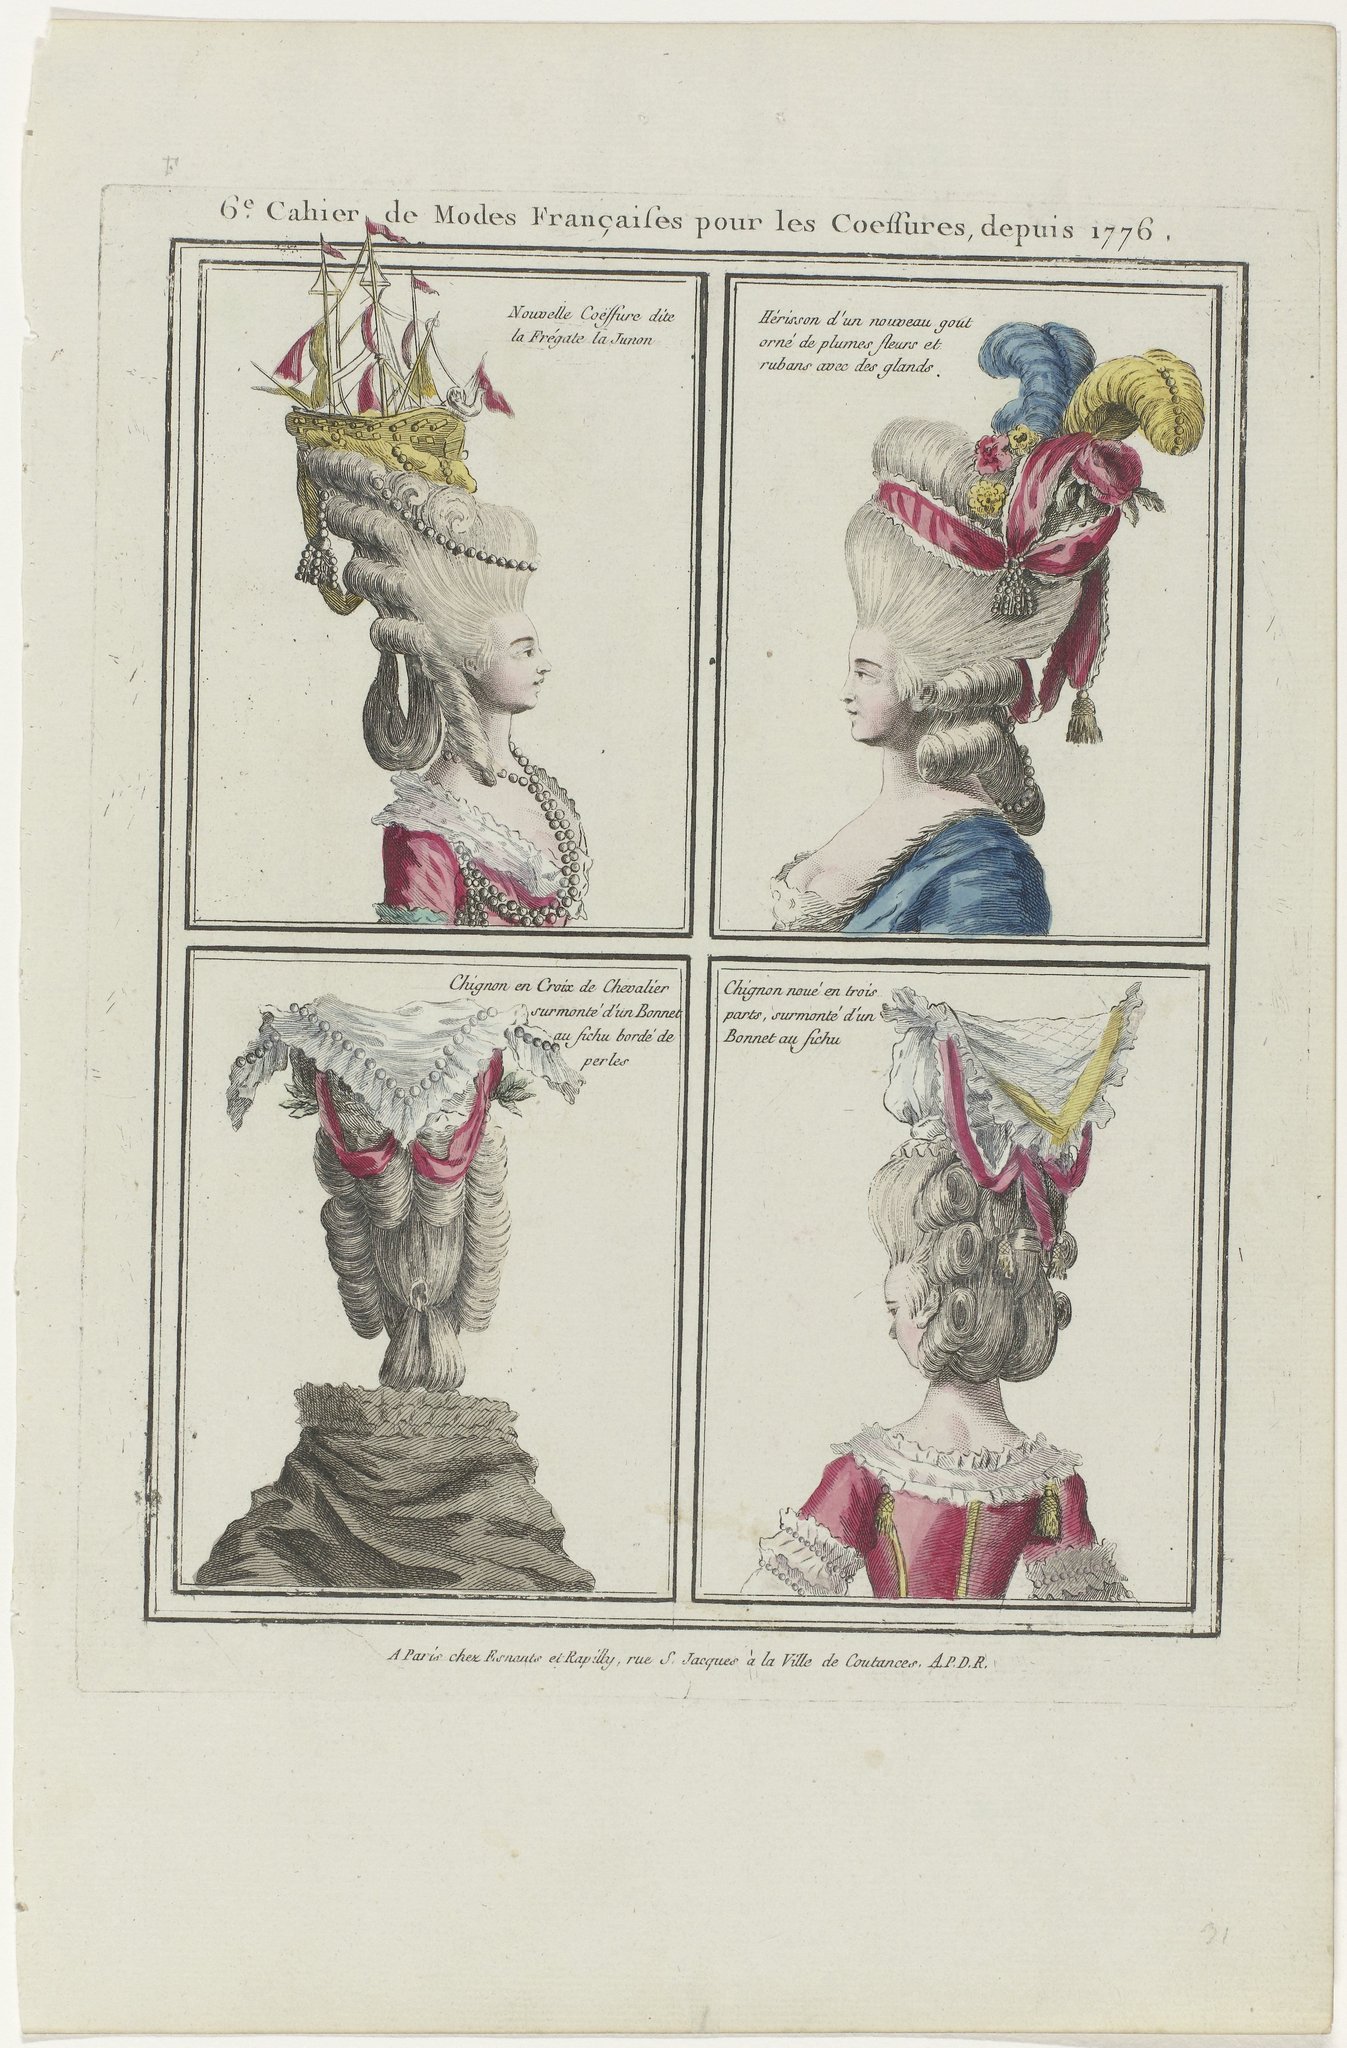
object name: fashion print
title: Coiffures, Poufs, Hats and Bonnets: Eleven Coiffures and Headdresses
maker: Anonymous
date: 1778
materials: paper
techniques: engraving, hand coloring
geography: paris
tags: clothing for the upper part of the body (+ women's clothes), border, ribbon, braid (+ women's clothes), styles of hairdress - aa - ~ women, head-gear: cap (+ women's clothes), fashion plates, necklace (+ women's clothes)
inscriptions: inscription: ‘Nouvelle Coëffure dite la Frégate la Junon / Hérisson d'un nouveau gout orné de plumes fleurs et rubans avec des glands. / Chignon en Croix de Chevalier surmonté d'un Bonnet au fichu bordé de perles / Chignon noué en trois parts, surmonté d'un Bonnet au fichu’, address: ‘A Paris chez Esnauts et Rapilly, rue St\. Jacques à la Ville de Coutances. A.P.D.R.’, title: ‘6e Cahier de Modes Françaises pour les Coeffures, depuis 1776.’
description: Ladies’ hairstyles were ingenious works of art, built around a core of cushions and horsehair. Hair was piled high in curls and twists (chignons) and adorned with feathers, ribbons, artificial flowers, tulle and jewels to create various fancifully named poufs. Because the hair was dressed using animal fat and powdered with wheat flour, these poufs attracted all manner of insects. Far from hygienic, they moreover did not last long. When they went out, ladies protected their hairdos with a voluminous ribbed hood called a calèche 1. Hairdressers of the time, who styled themselves as artists, used prints to advertise their latest creations and craftsmanship 2 3.